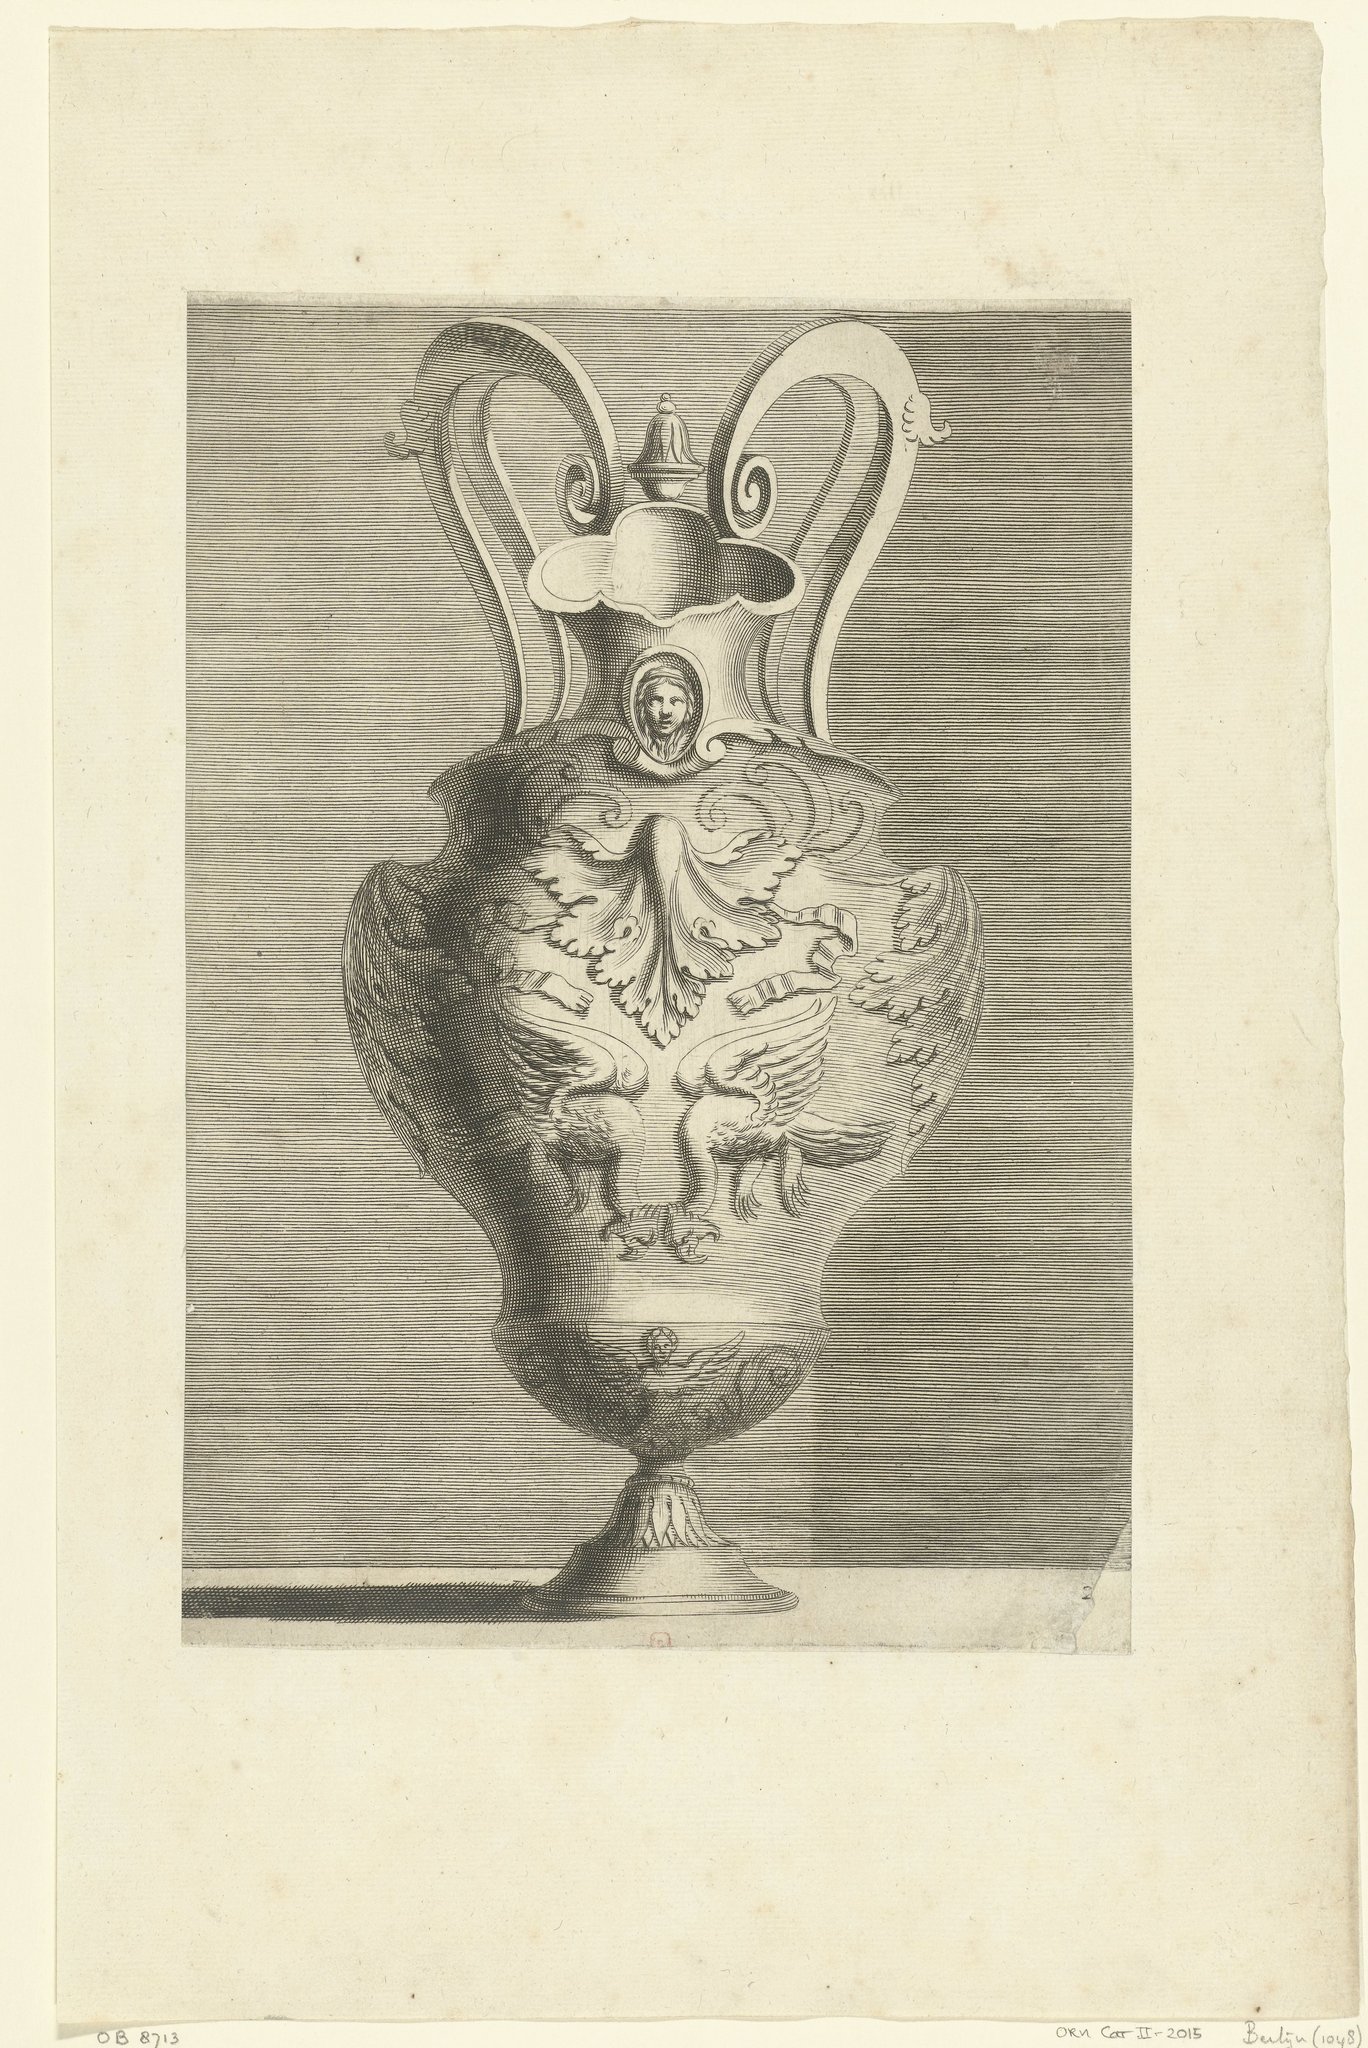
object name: ornament print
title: Livre de Vases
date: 1657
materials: paper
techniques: engraving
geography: france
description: Het lichaam is gedecoreerd met bladeren en twee roofvogels, de handvatten bestaan uit dubbele platte consoles. Blad 2 uit serie van 24 bladen, genummerd: 1-21, 23-25.